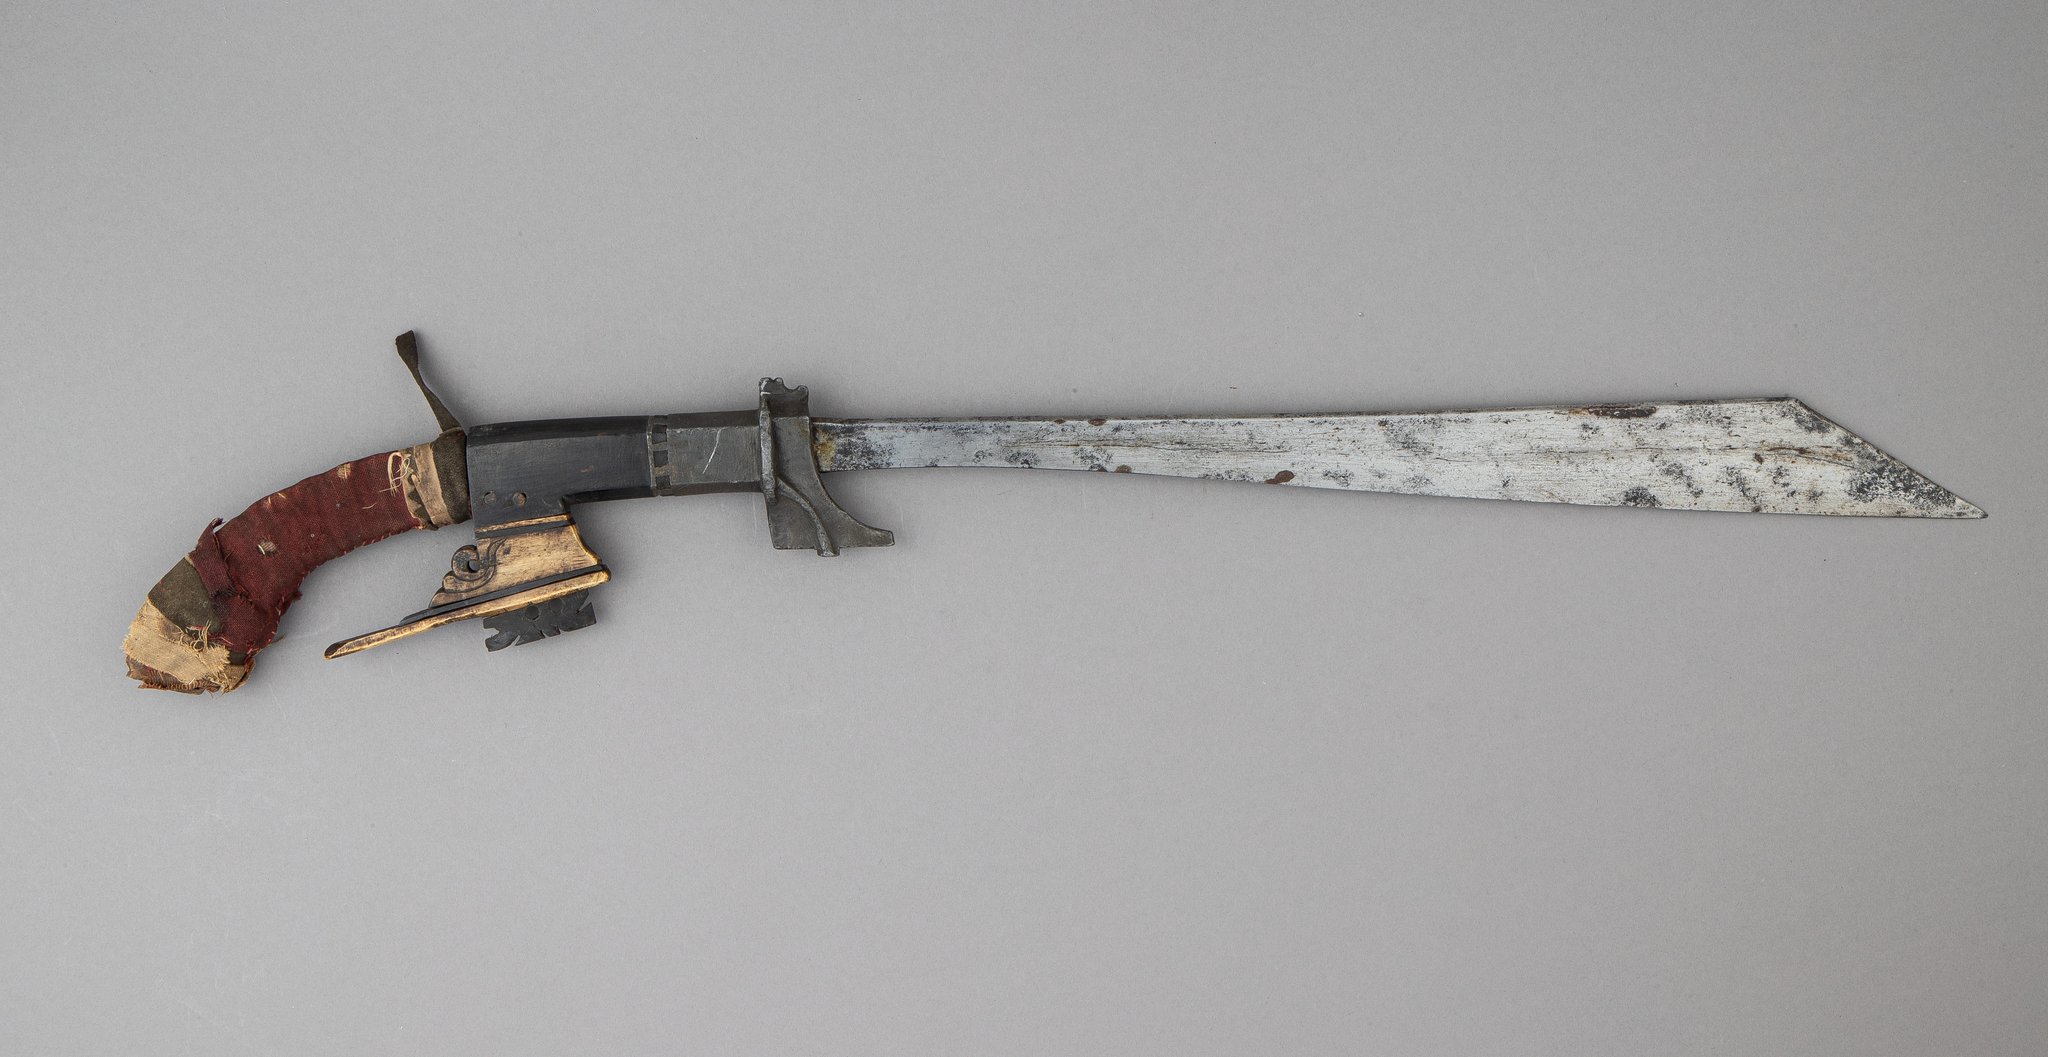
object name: sword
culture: indonesian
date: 1701-1900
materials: bone, textile, horn, lead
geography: indonesia